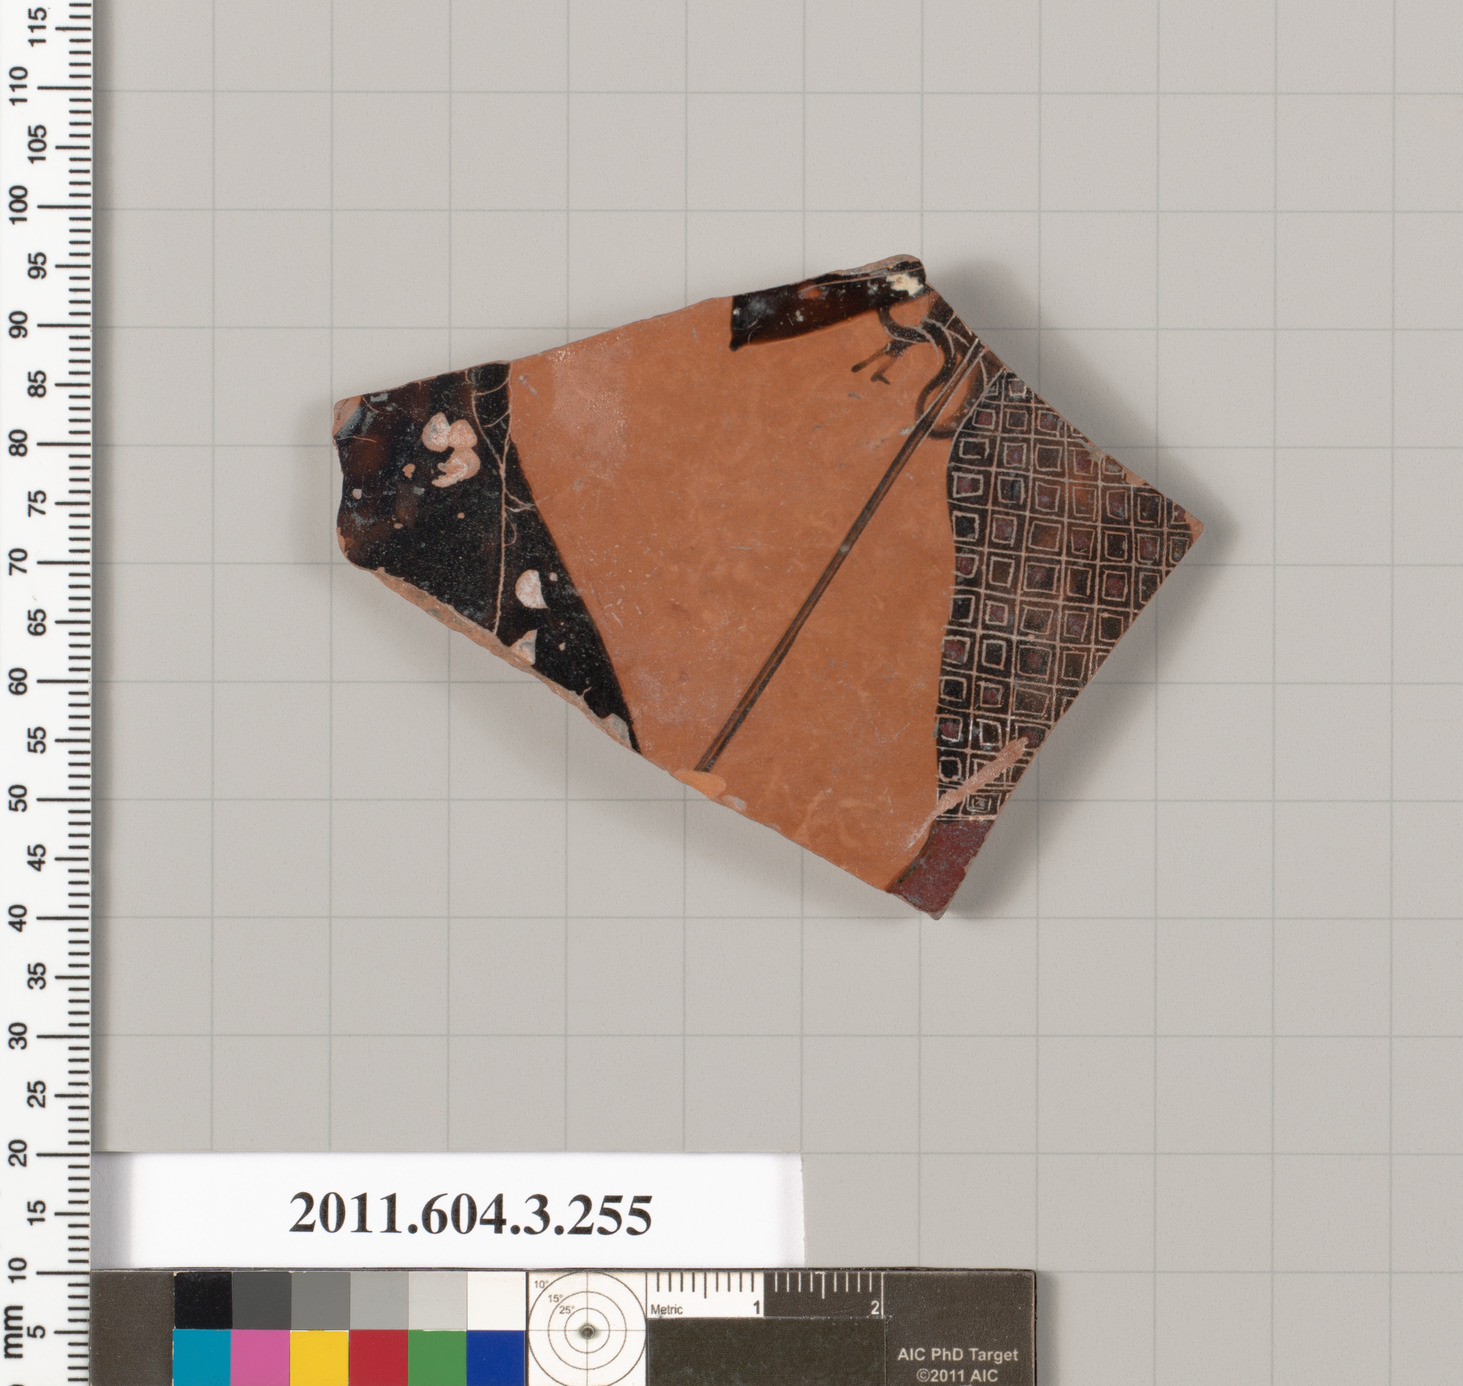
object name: neck amphora fragment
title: Terracotta fragment of a neck-amphora (jar)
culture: greek, attic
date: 540-530 BCE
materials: terracotta